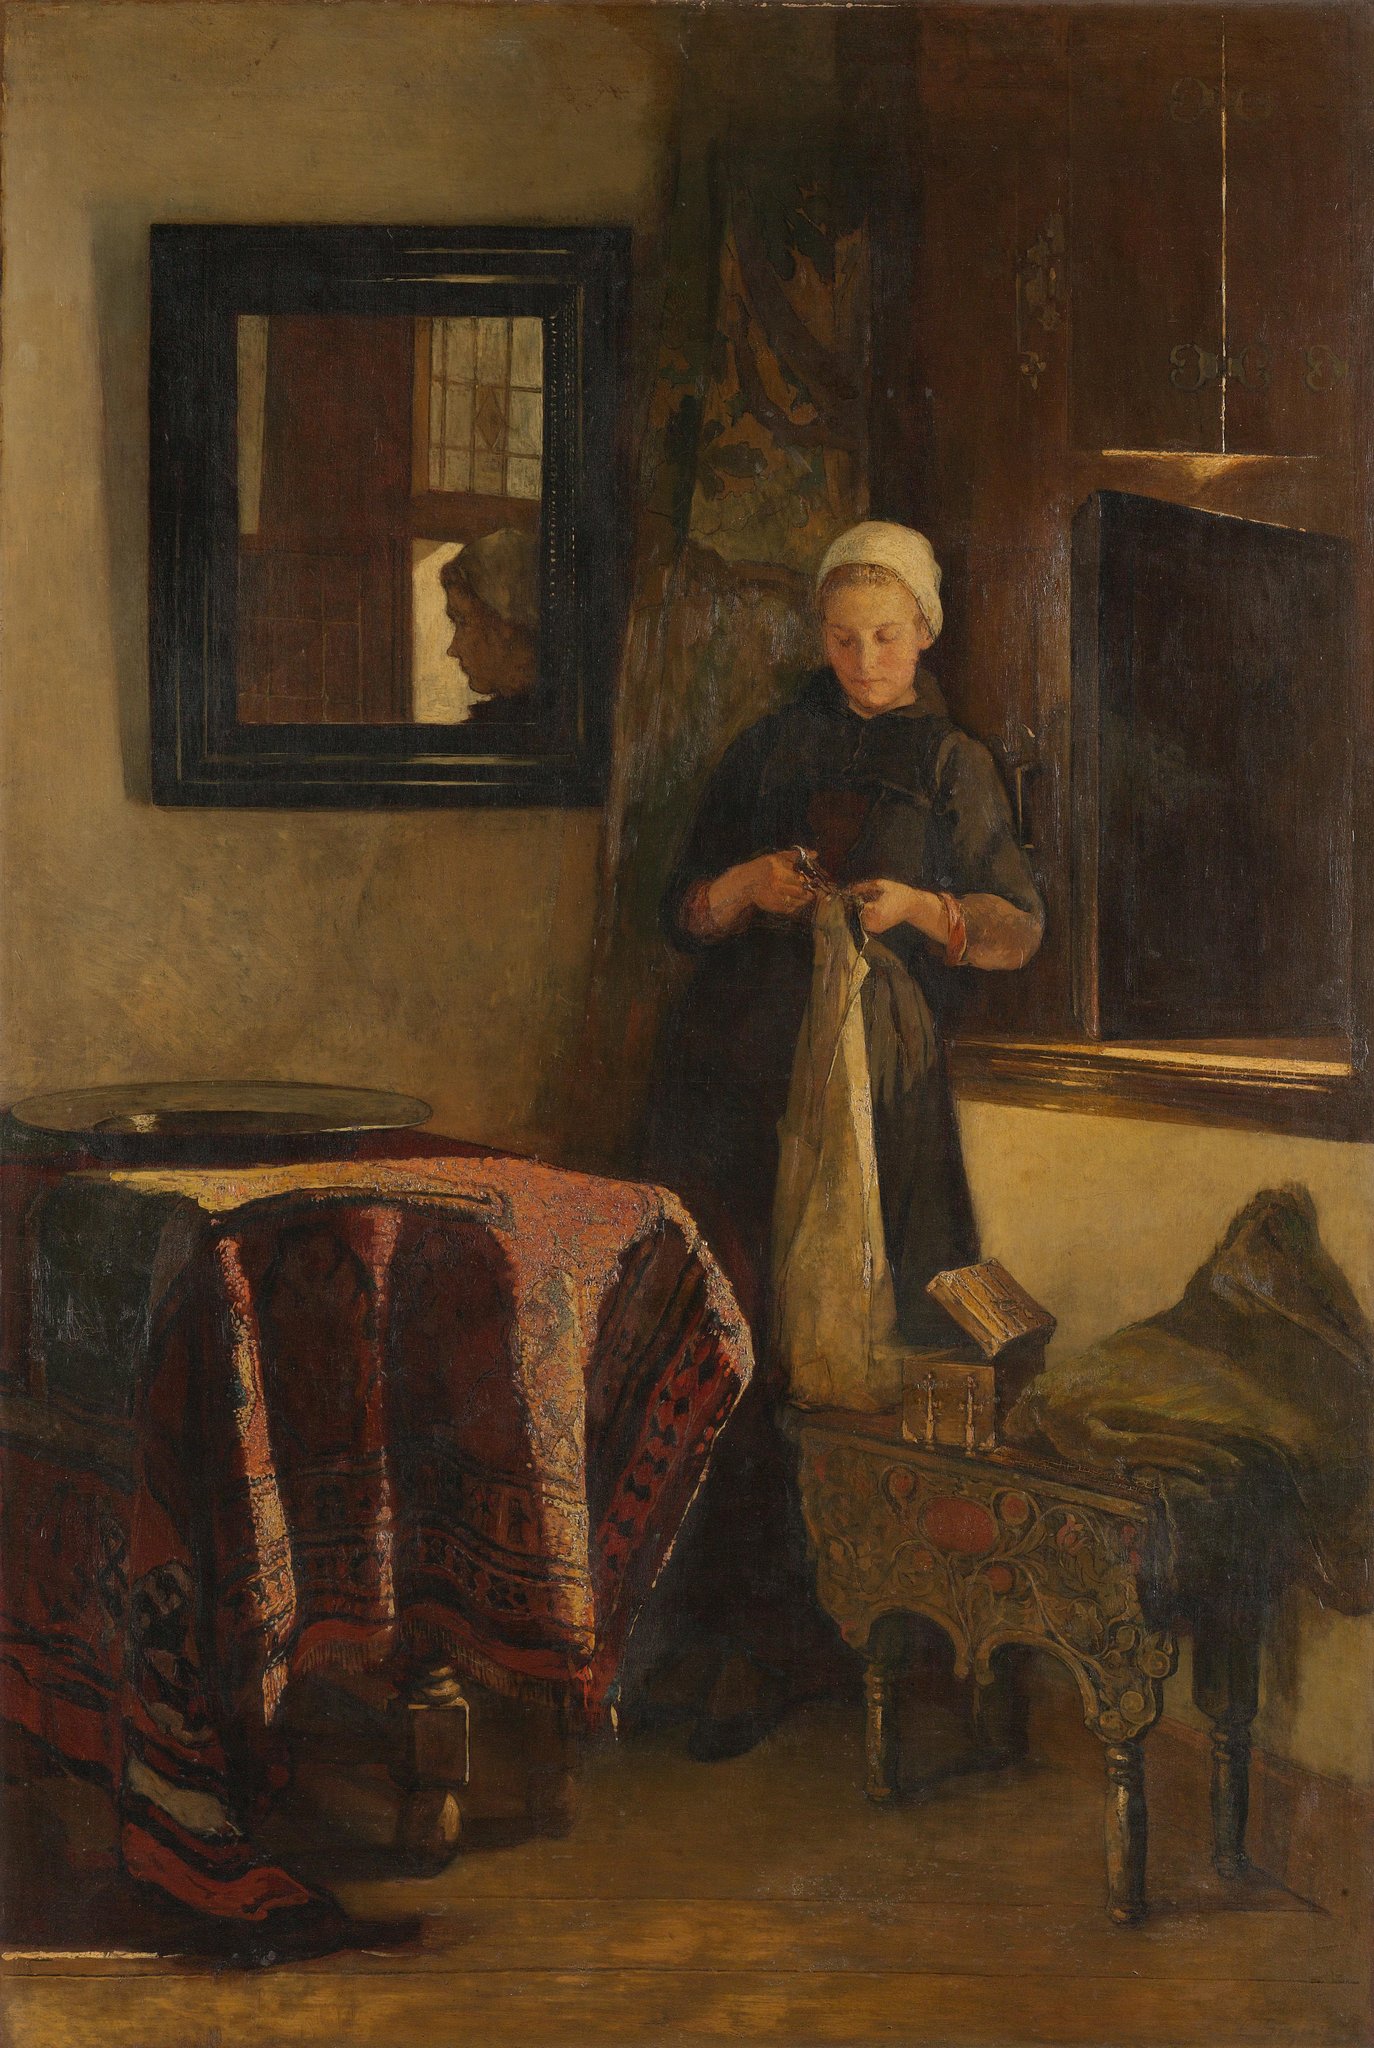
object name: painting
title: A Sunny Corner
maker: christoffel bisschop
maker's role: draughtsman, print maker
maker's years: 1828-1904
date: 1850-1888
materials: canvas, oil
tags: interior of the house, sewing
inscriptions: signature: ‘C. Bisschop’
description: Bisschop made his name with pictures of the striking, traditional interiors found in Hindeloopen, a village in the province of Friesland. Typical of this decor are the colourful curtain, Persian table carpet and richly painted drop-leaf table with a small sewing box. A young woman stands close to the window to catch the sunlight on her handiwork through the halfopened shutters. Her concentrated face is also visible in the mirror.